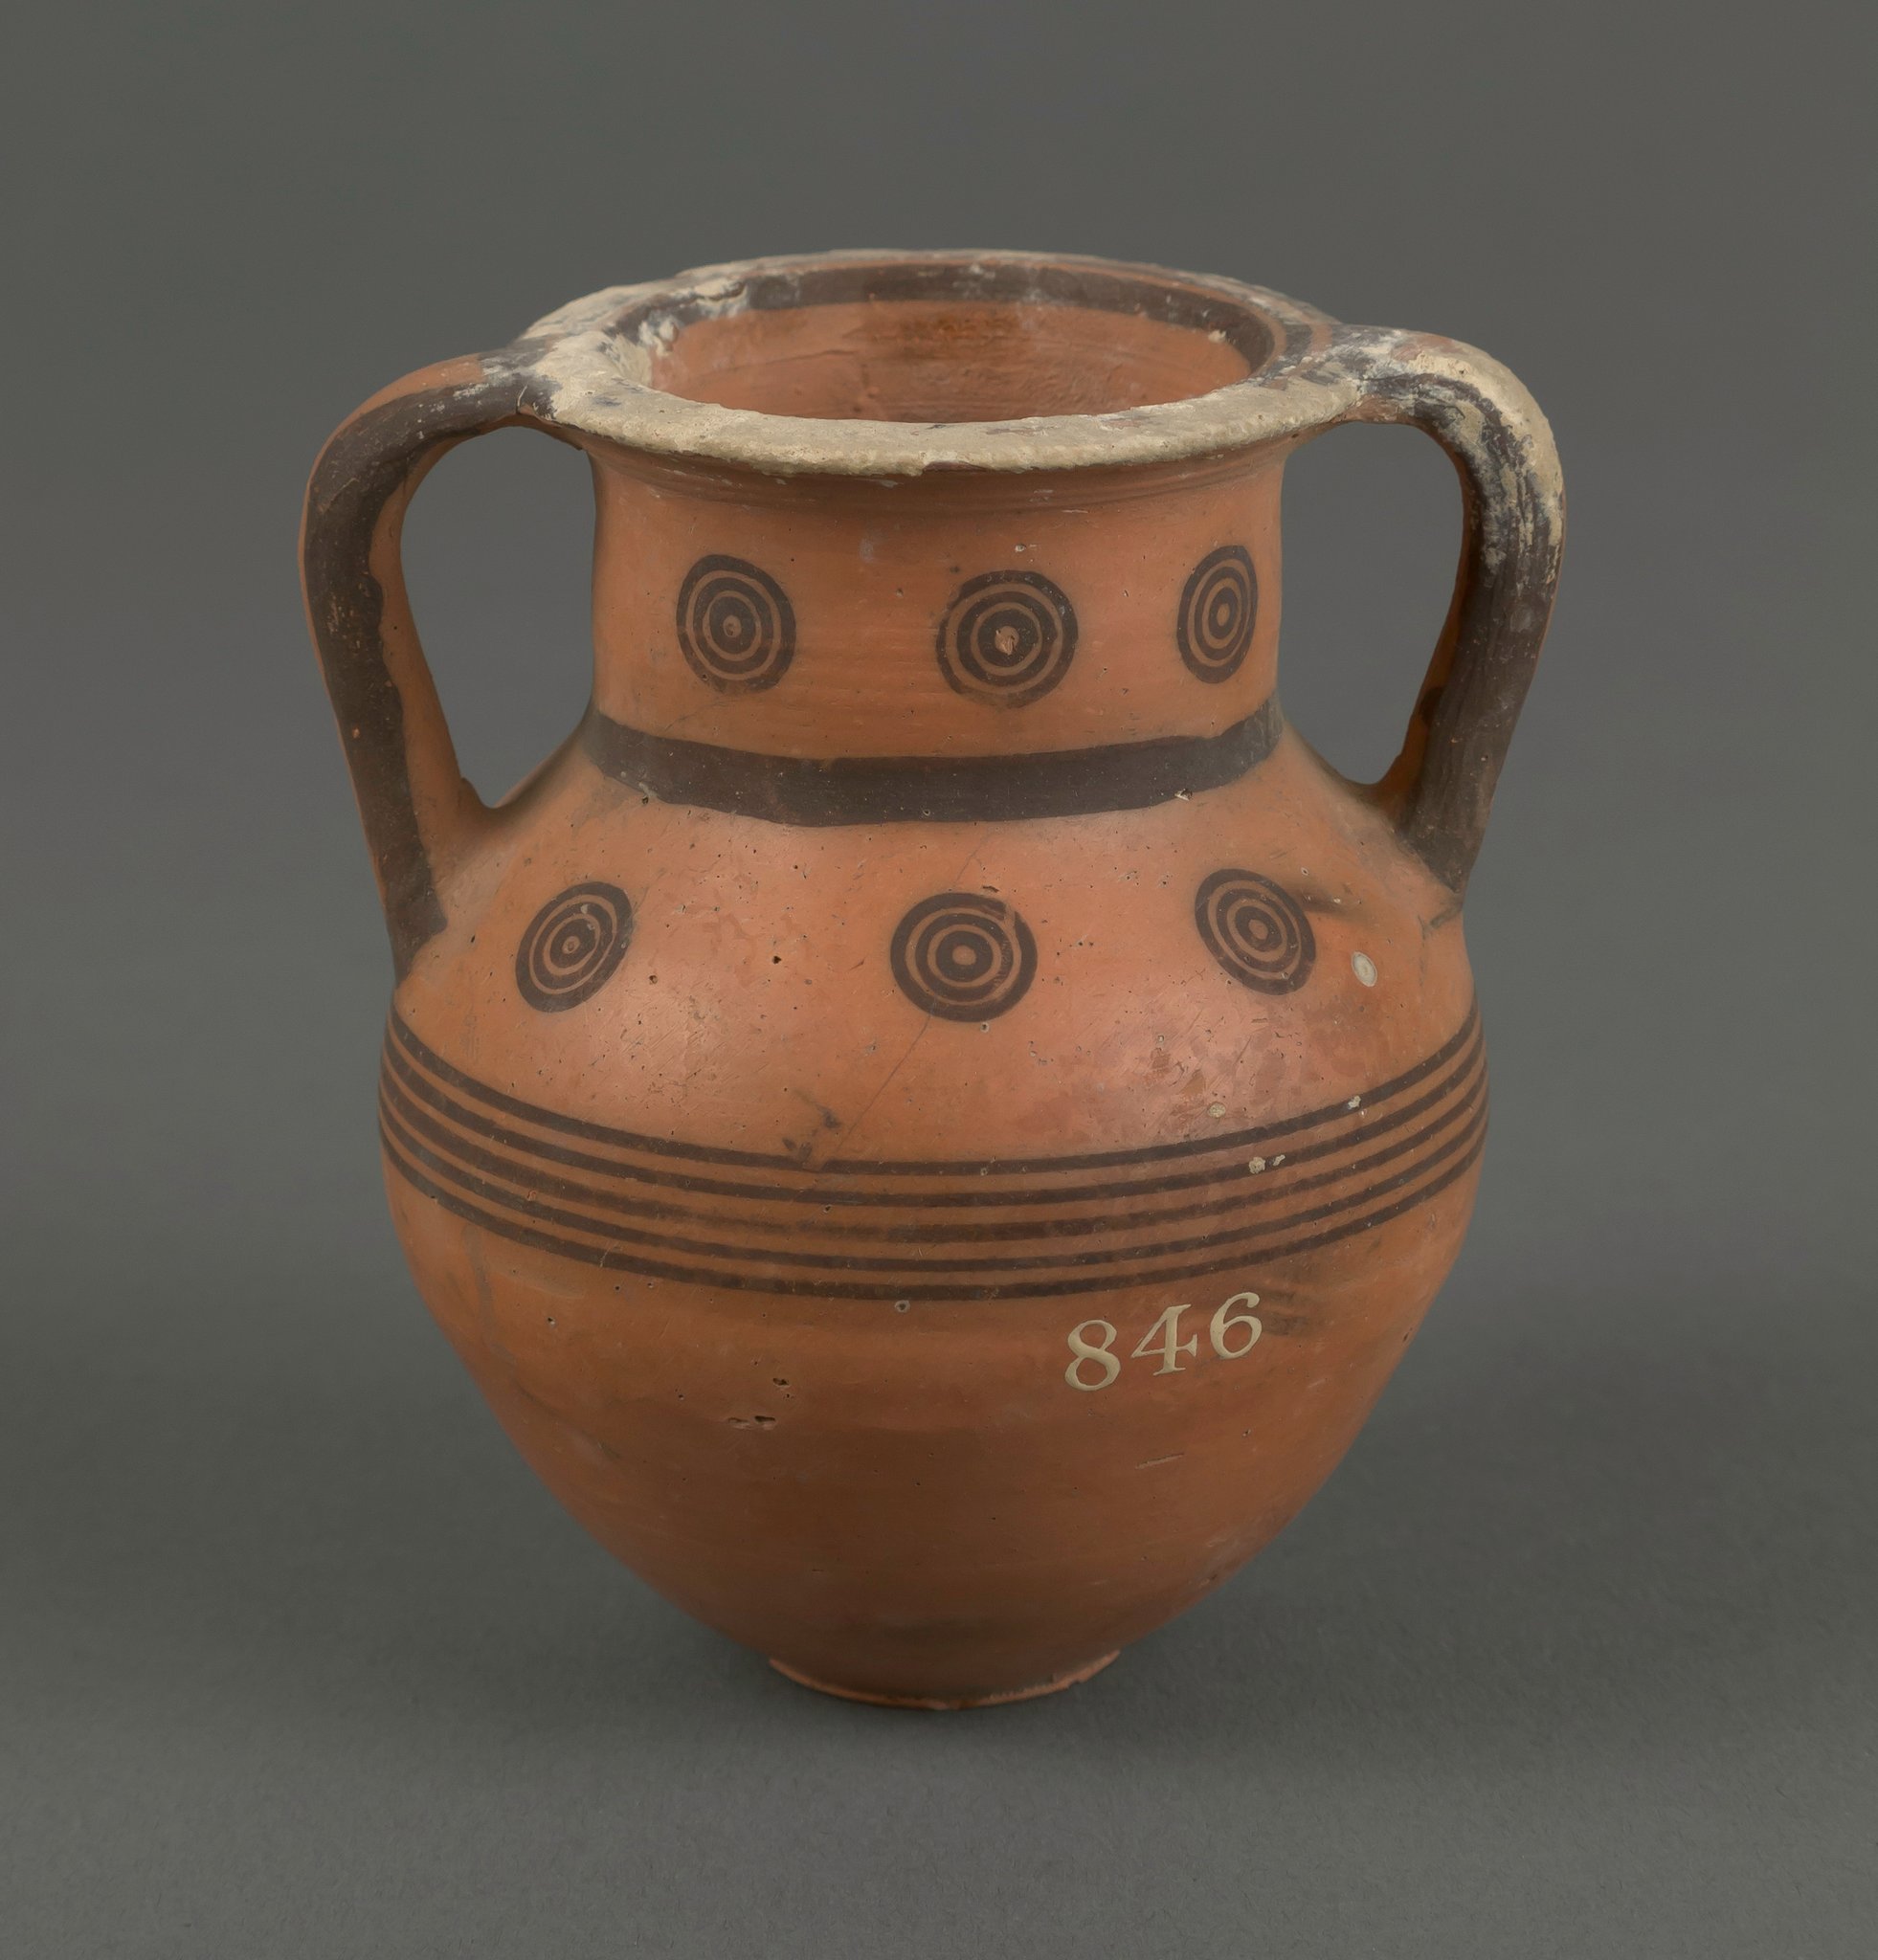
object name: amphora, miniature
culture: cypriot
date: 1050-900 BCE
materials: terracotta